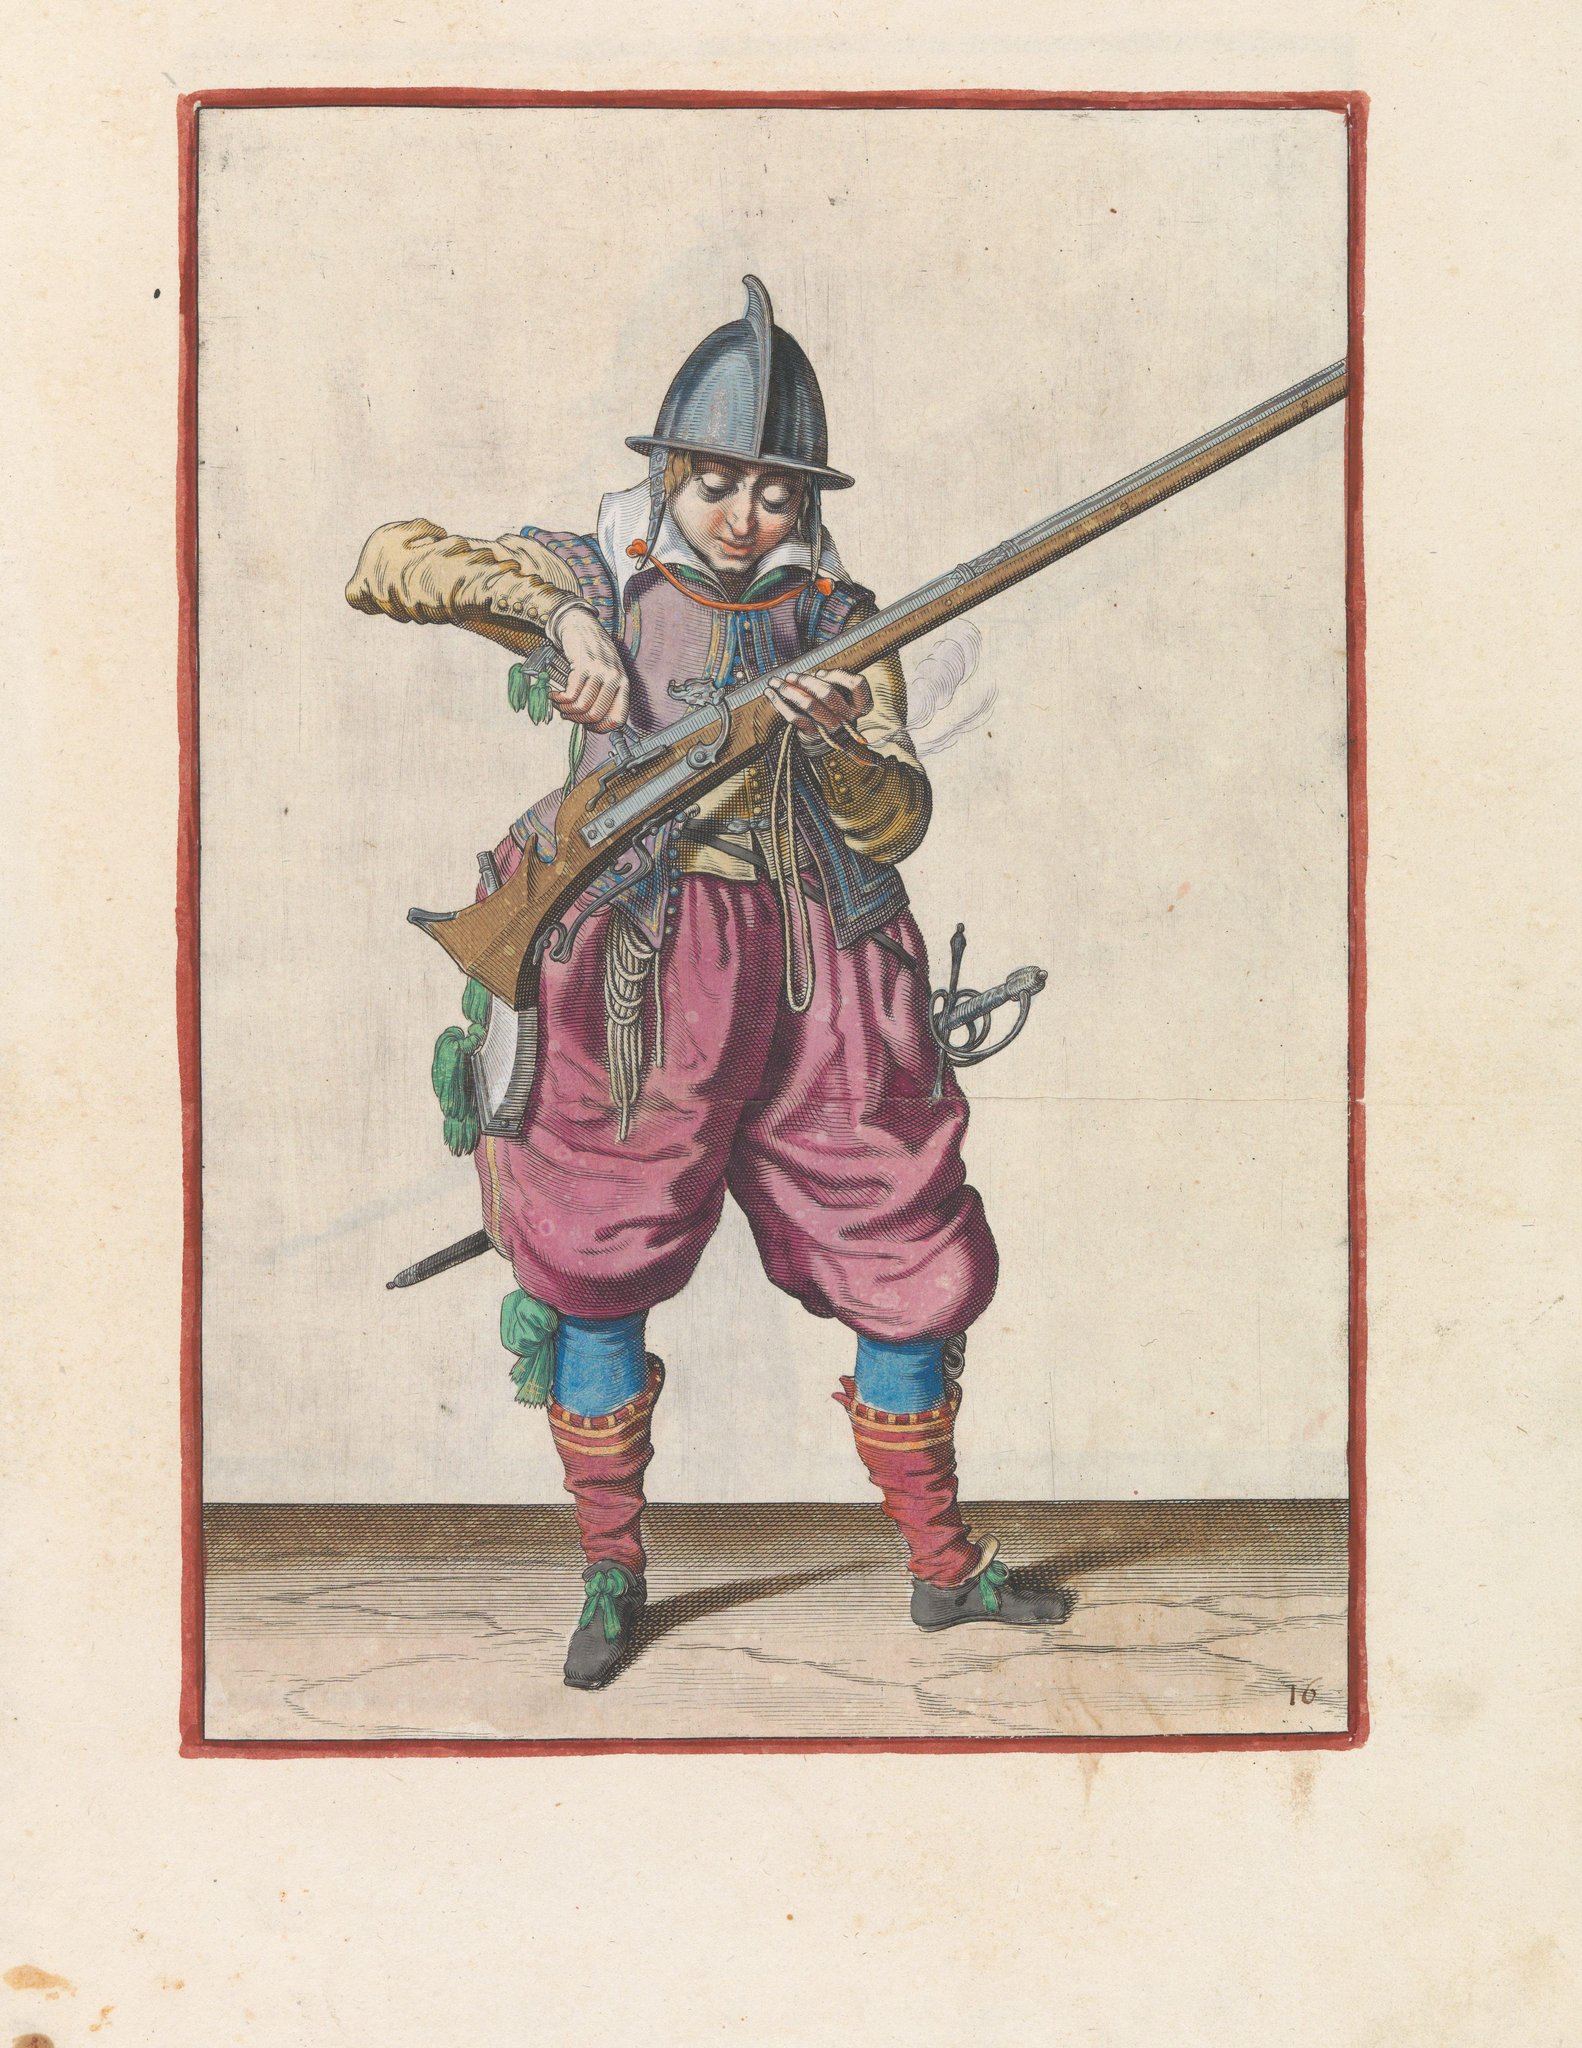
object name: print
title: Soldaat die kruit in de pan van zijn roer giet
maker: jacques de gheyn (ii)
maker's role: painter, print maker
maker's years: 1565-1629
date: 1597-1607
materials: paper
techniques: engraving, hand coloring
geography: the hague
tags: handling of weapons ~ military training, firearms: rifle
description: Een soldaat, ten voeten uit, die kruit uit een kruitfles in de pan (het kruitreservoir) van een roer (een bepaald type vuurwapen) giet. In zijn linkerhand behalve het roer ook een brandende lont. Deze prent is onderdeel van de reeks van 42 met de hand genummerde prenten van roerschutters in de Wapenhandelinghe.